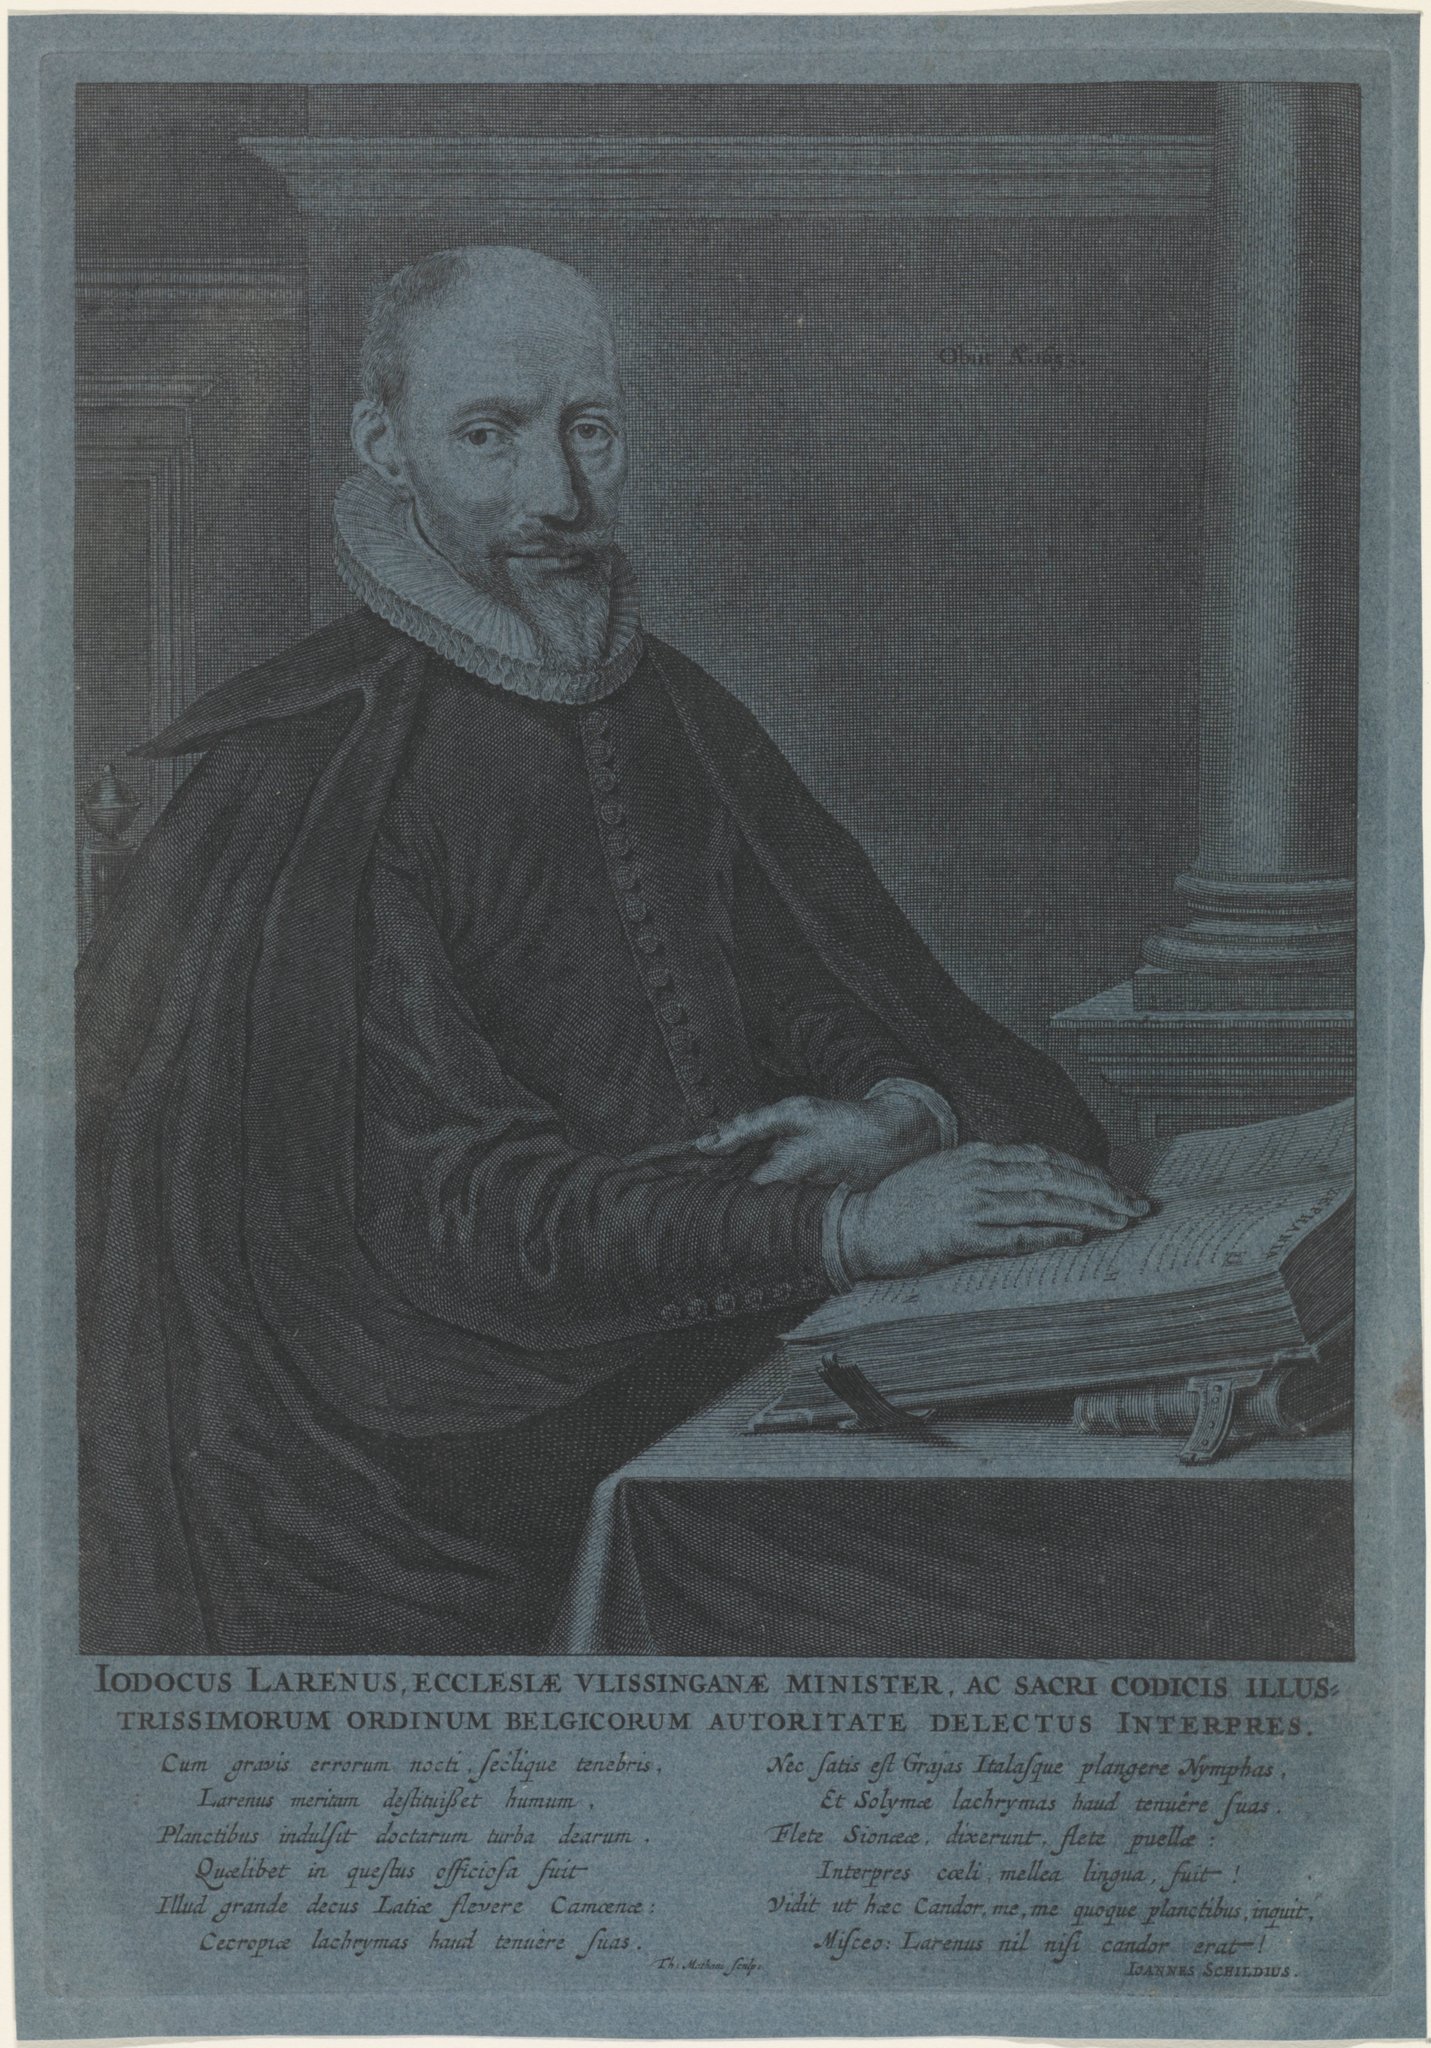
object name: print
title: Portret van Joost van Laren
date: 1653-1676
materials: paper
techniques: engraving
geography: northern netherlands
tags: flushing, joost van laren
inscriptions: collector's mark: Lugt 2228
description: Portret van de theoloog Joost van Laren.